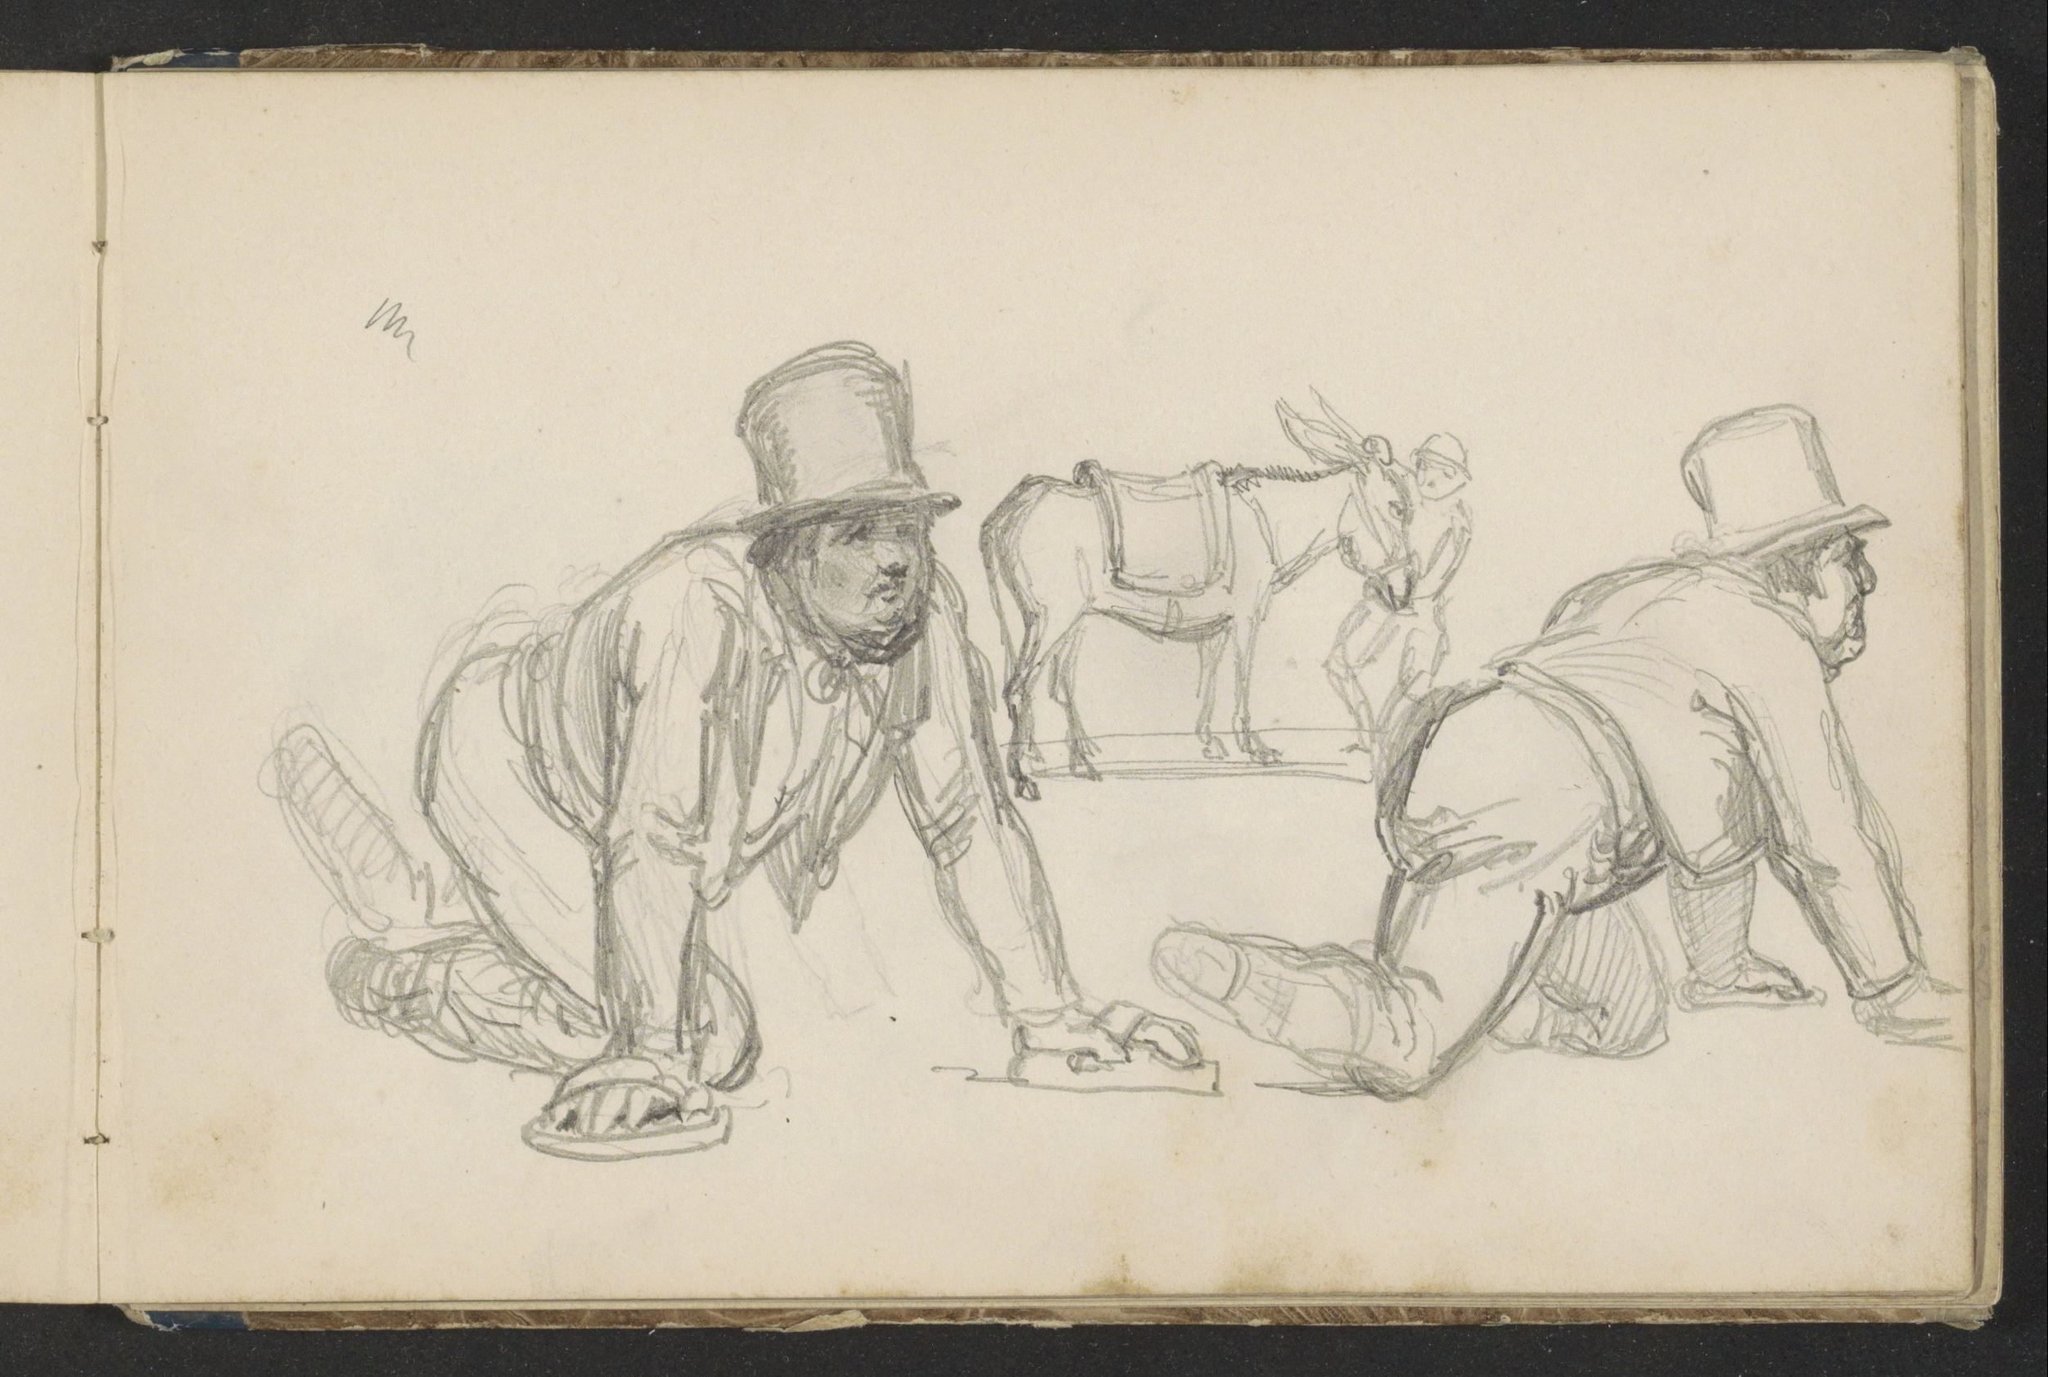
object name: sketchbook leaf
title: Twee mannen die op de knieën een straat of vloer schrobben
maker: Anonymous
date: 1841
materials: paper, pencil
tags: ass, donkey, kneeling figure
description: De twee mannen dragen hoeden en hebben sponzen om hun handen waarmee ze knielend een vloer of straat schrobben. Eén van de mannen, of beide mannen, hebben een houten been. Op de achtergrond een man bij een gezadelde ezel. Blad 12 recto uit een schetsboek met 33 bladen.